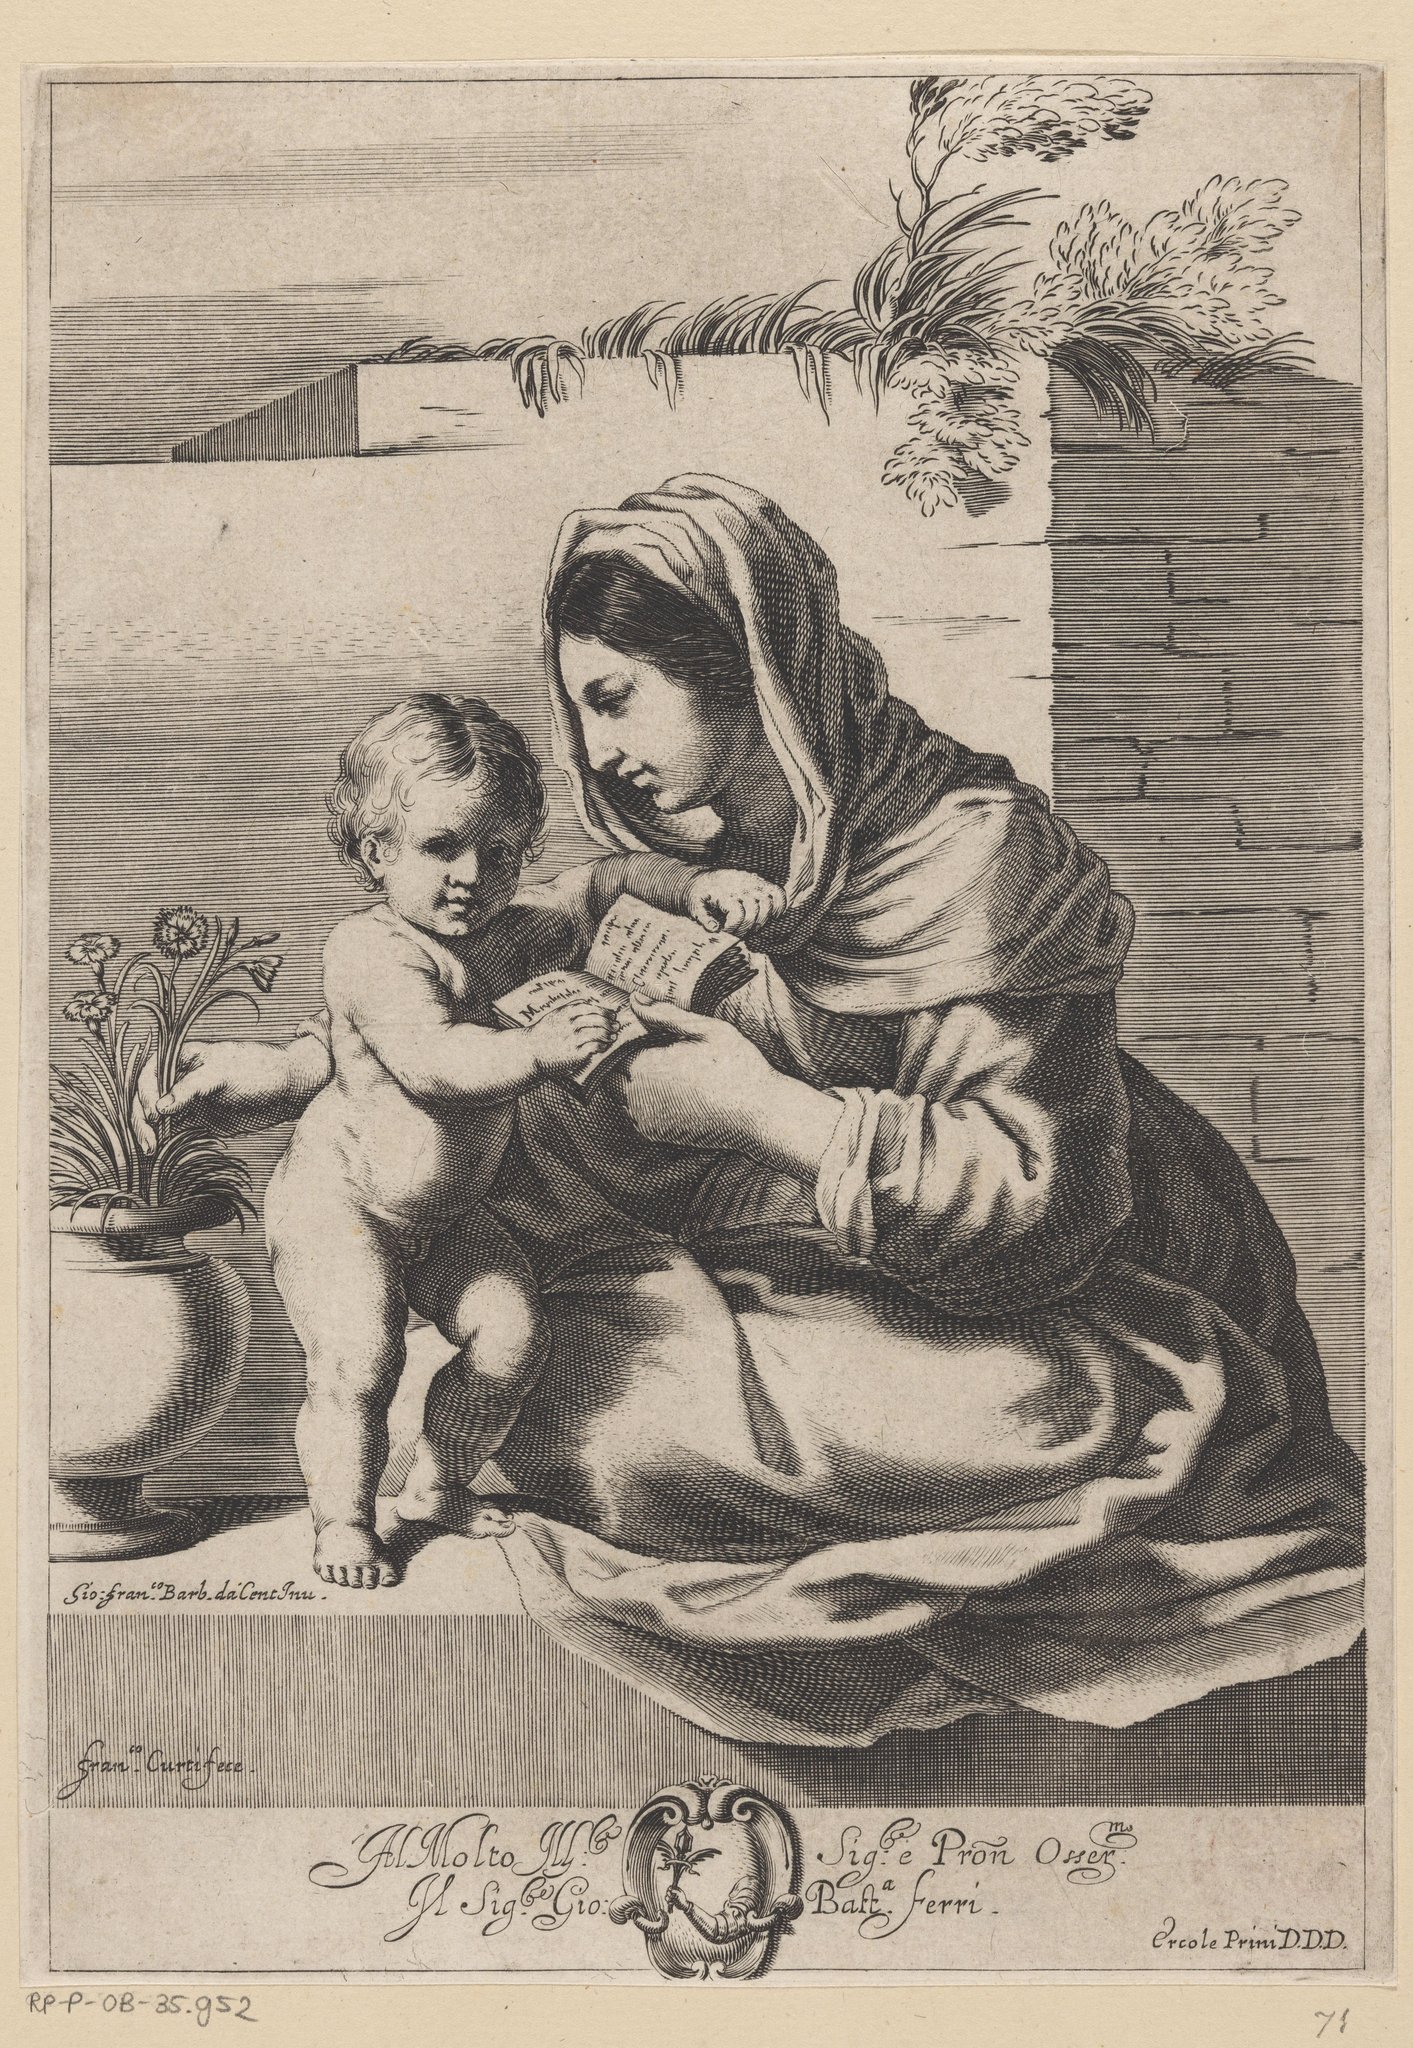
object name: print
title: Maria met Kind met boek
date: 1613-1670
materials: paper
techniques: engraving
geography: italy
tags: madonna: i.e. mary with the christ-child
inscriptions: collector's mark: Lugt 240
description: Maria zit geknield naast het Christuskind en houdt hem een boek voor. Met haar andere hand plukt ze een bloem. In ondermarge tekst en een wapenschild.